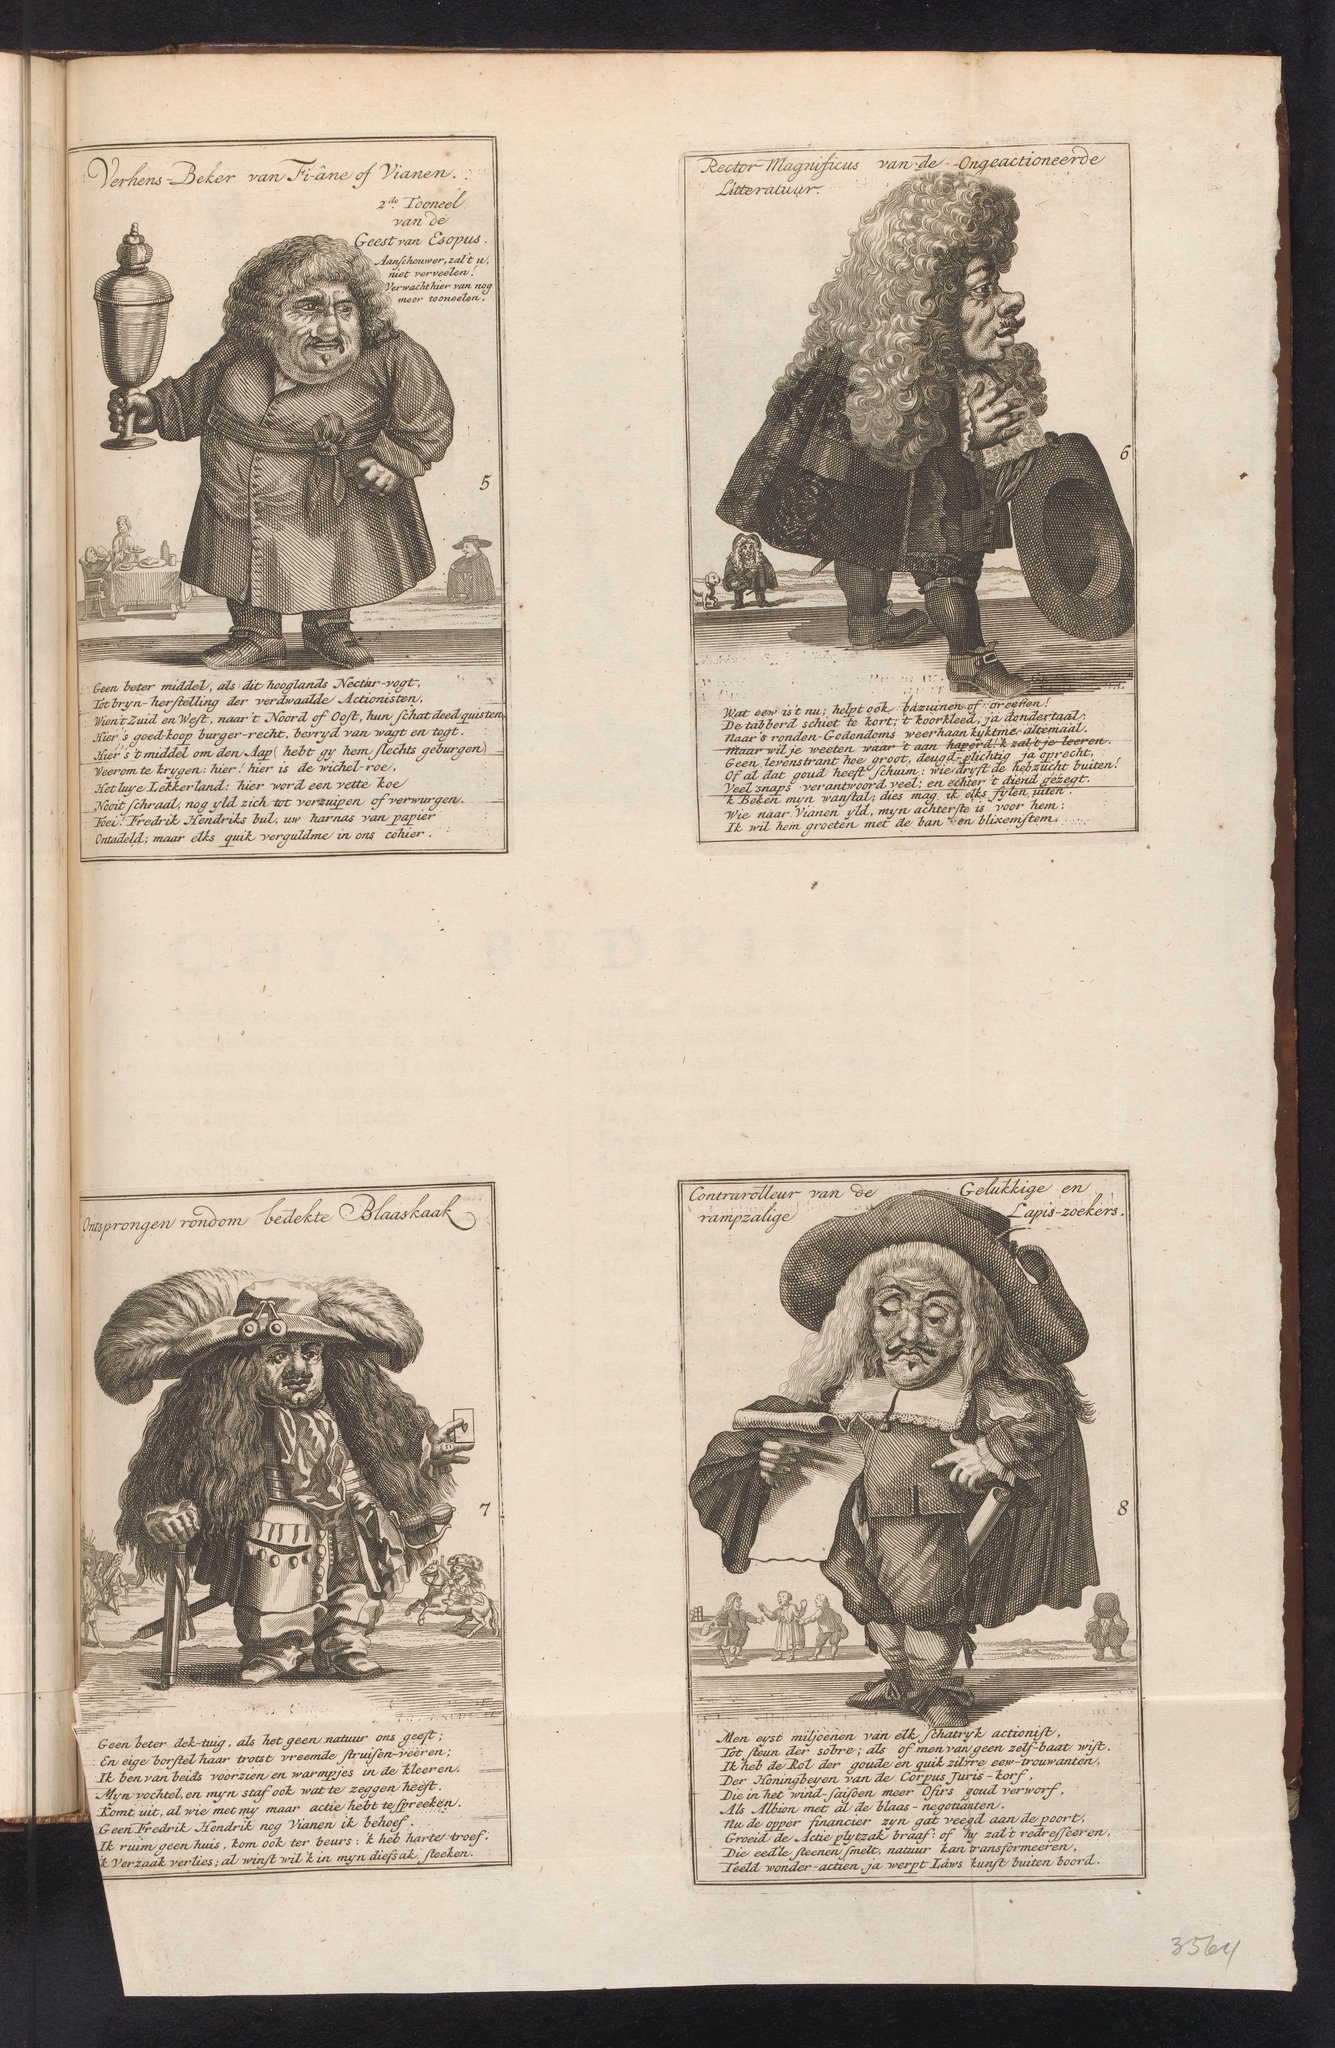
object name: caricature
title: Blad met karikaturen van dwergen en de windhandel, 1720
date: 1720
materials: paper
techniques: engraving, etching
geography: northern netherlands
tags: caricatures (human types), little people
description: Blad met karikaturen van kleine mensen in de windhandel met een verwijzing in de onderschriften naar Vianen. Vier afzonderlijke platen genummerd 5-8 op één blad afgedrukt. Plaat 5: een kleine mens in kamerjas met een grote beker. Plaat 6: een kleine mens met een grote pruik, de hoed in de hand. Plaat 7: een kleine mens als officier met grote verenhoed en een speelkaart in de hand. Plaat 8: een kleine mens met hoed die een rol papier leest. Deze bladen 5-8 hebben in het onderschrift in vers in tien regels. Prent in de gebonden eerste uitgave (304 B 11) van Het Groote Tafereel der Dwaasheid met spotprenten op de Windhandel of Actiehandel van 1720.